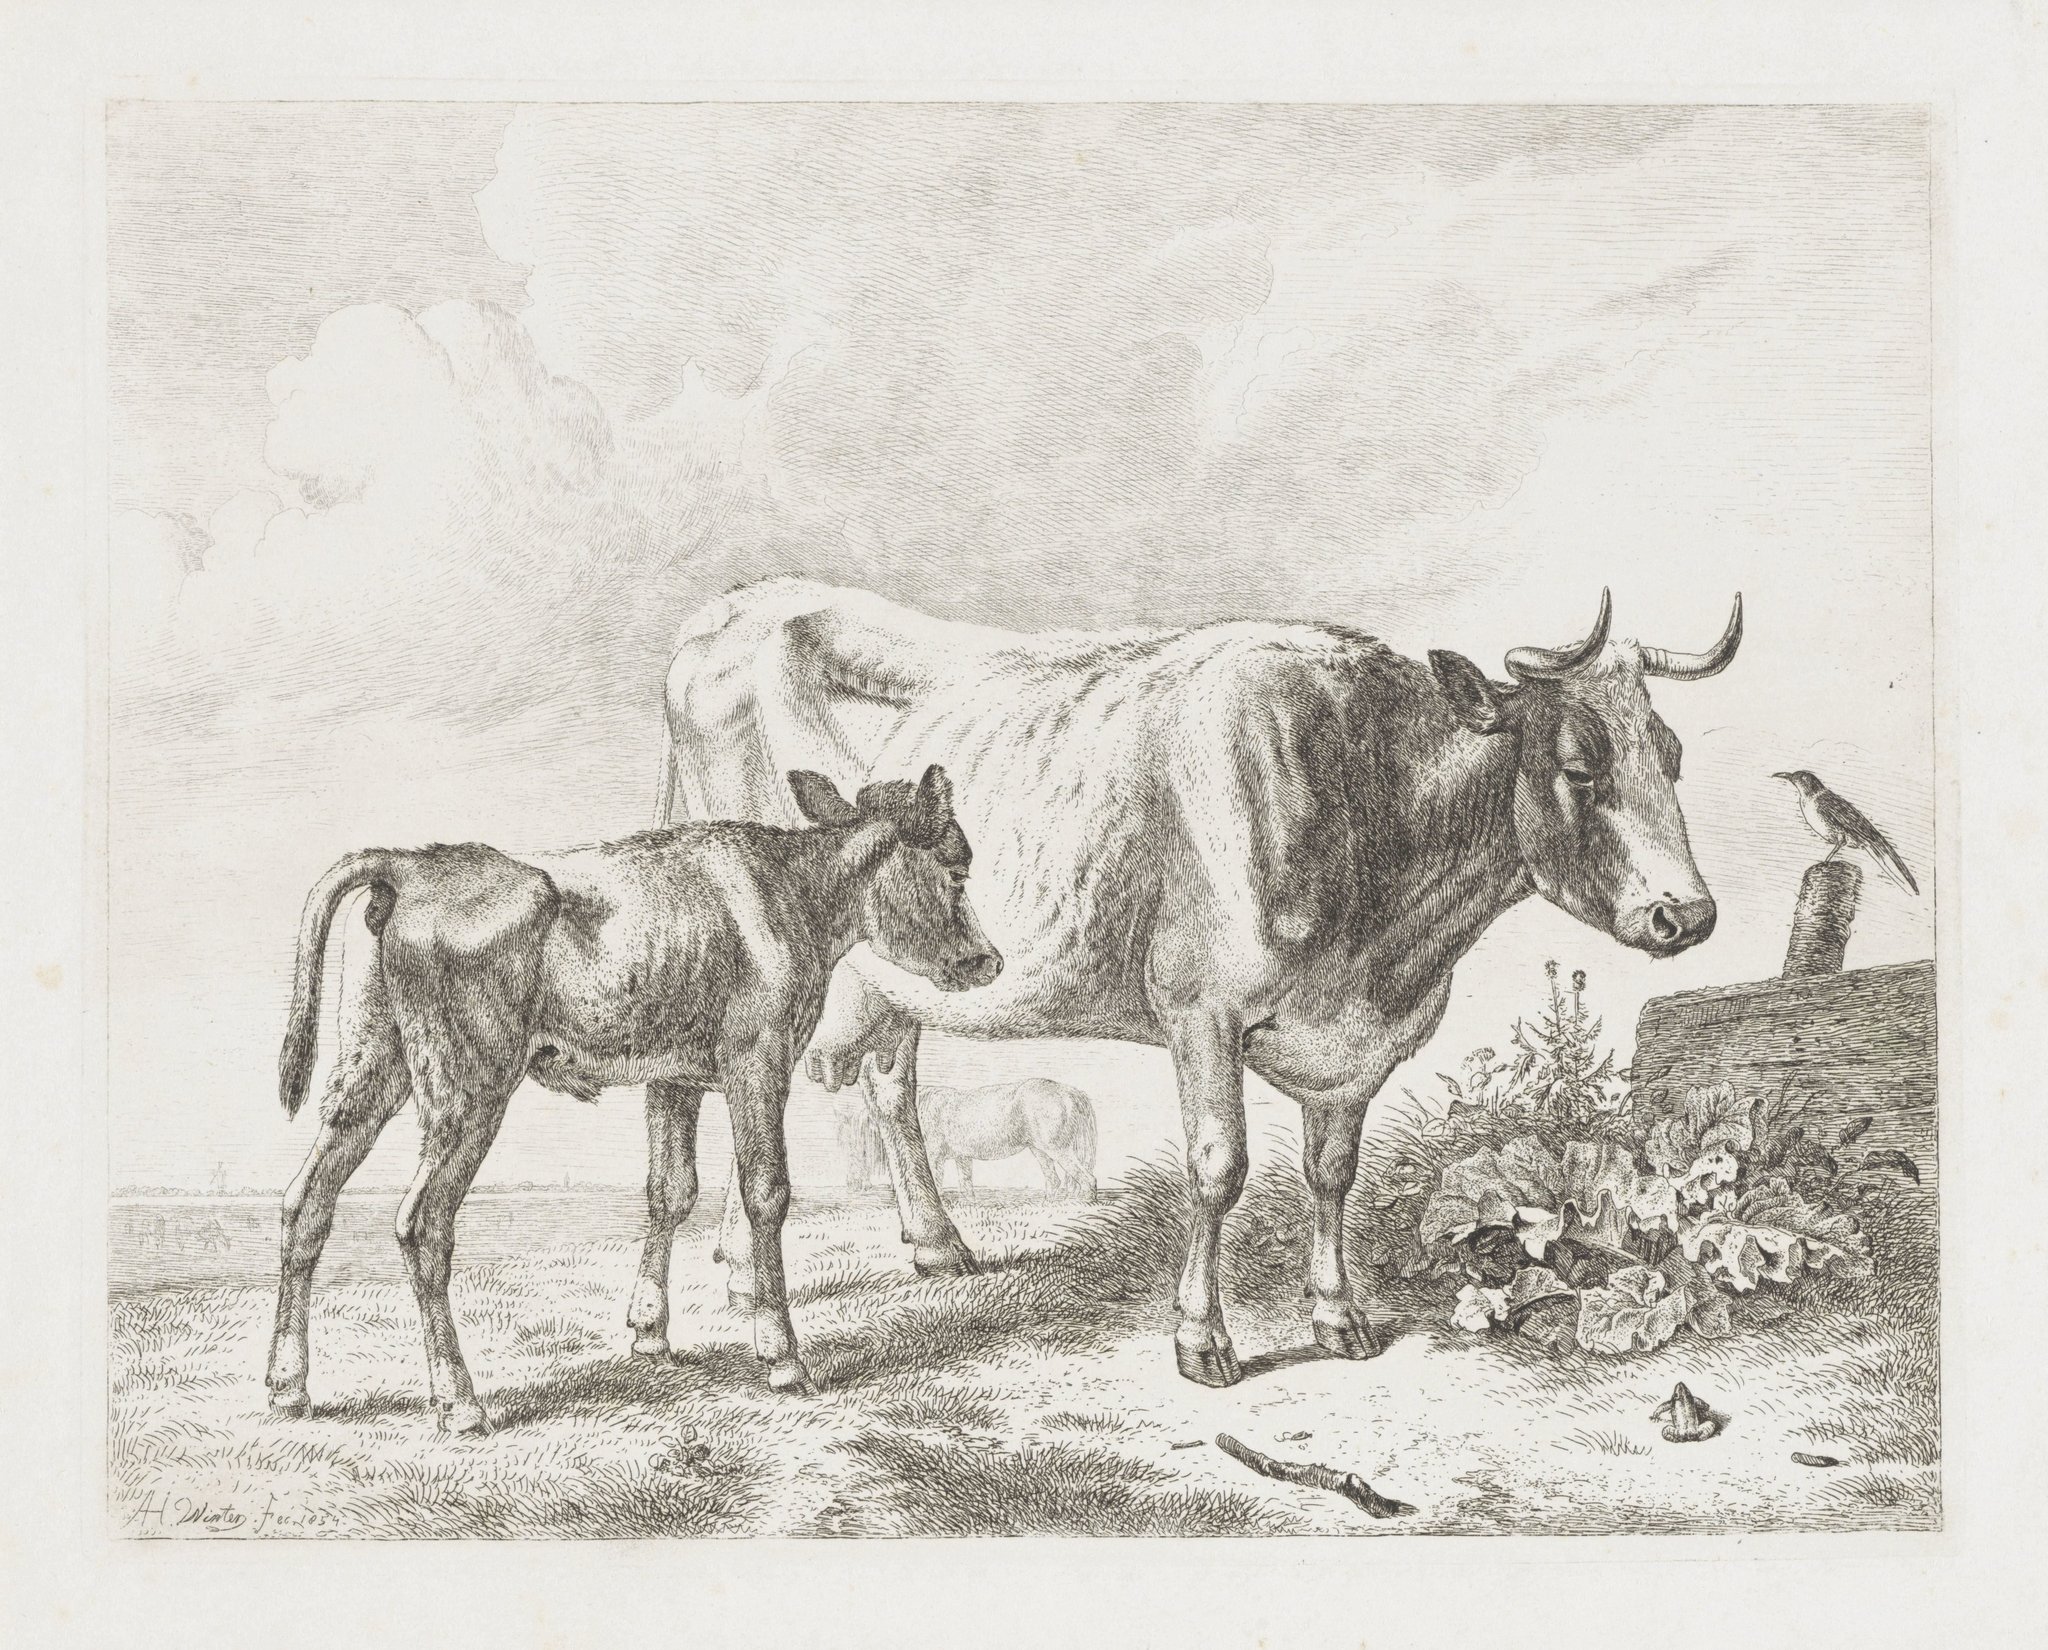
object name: print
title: Koe en een kalf in een weiland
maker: abraham hendrik winter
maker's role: painter, print maker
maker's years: 1800-1861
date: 1854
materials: paper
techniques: etching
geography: utrecht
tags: tailless amphibians: frog, cow, birds, calf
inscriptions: collector's mark: Lugt 2228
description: In een weiland staat een kalf bij een koe. Voor de koe zit een vogel op een paal. Rechtsvoor zit een kikker en in de verte staat een paard.